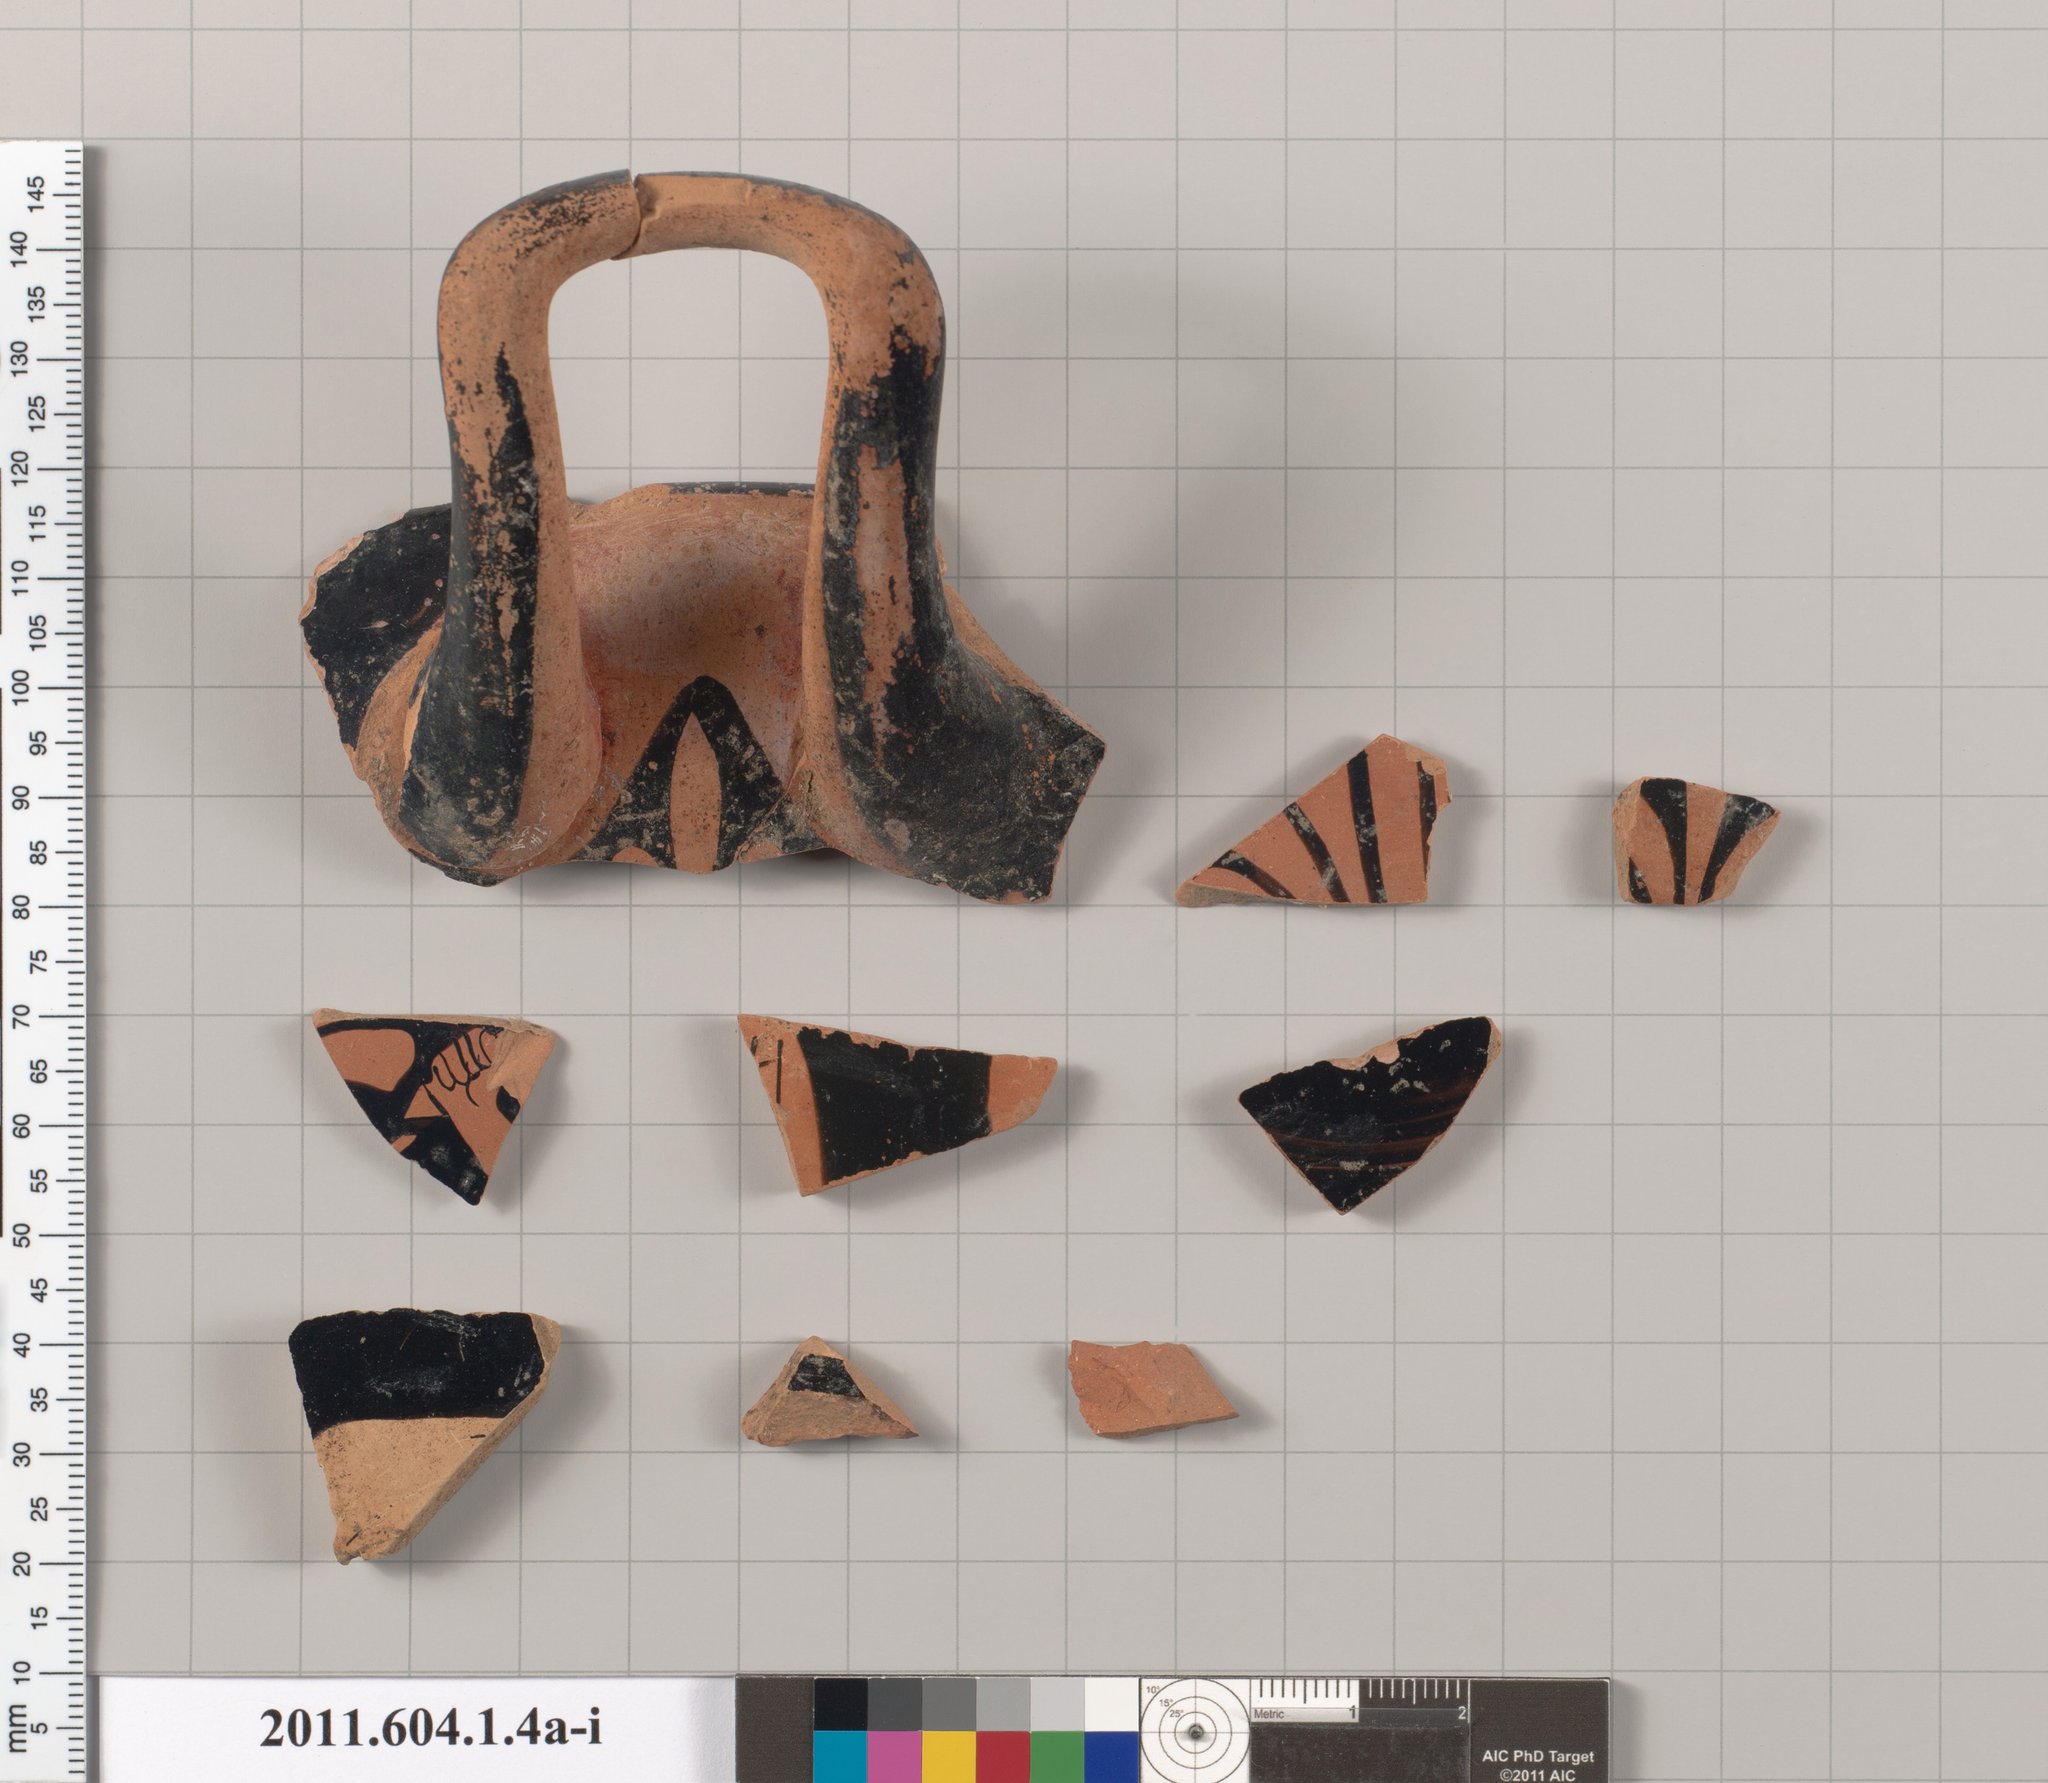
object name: kylix fragment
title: Terracotta fragments of a kylix (drinking cup)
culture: greek, attic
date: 467-435 BCE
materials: terracotta